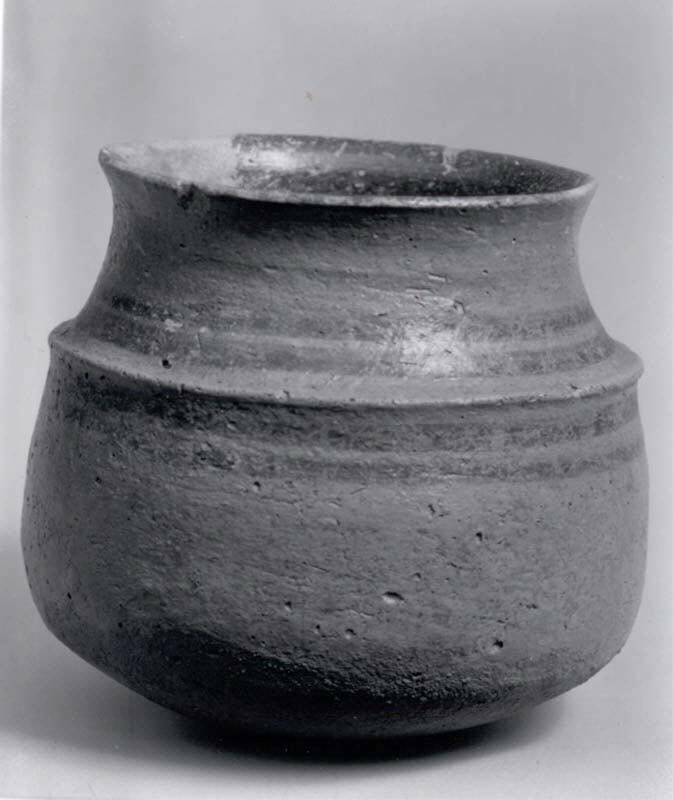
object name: jar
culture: iranian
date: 2000-1600 BCE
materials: ceramic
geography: iran, luristan